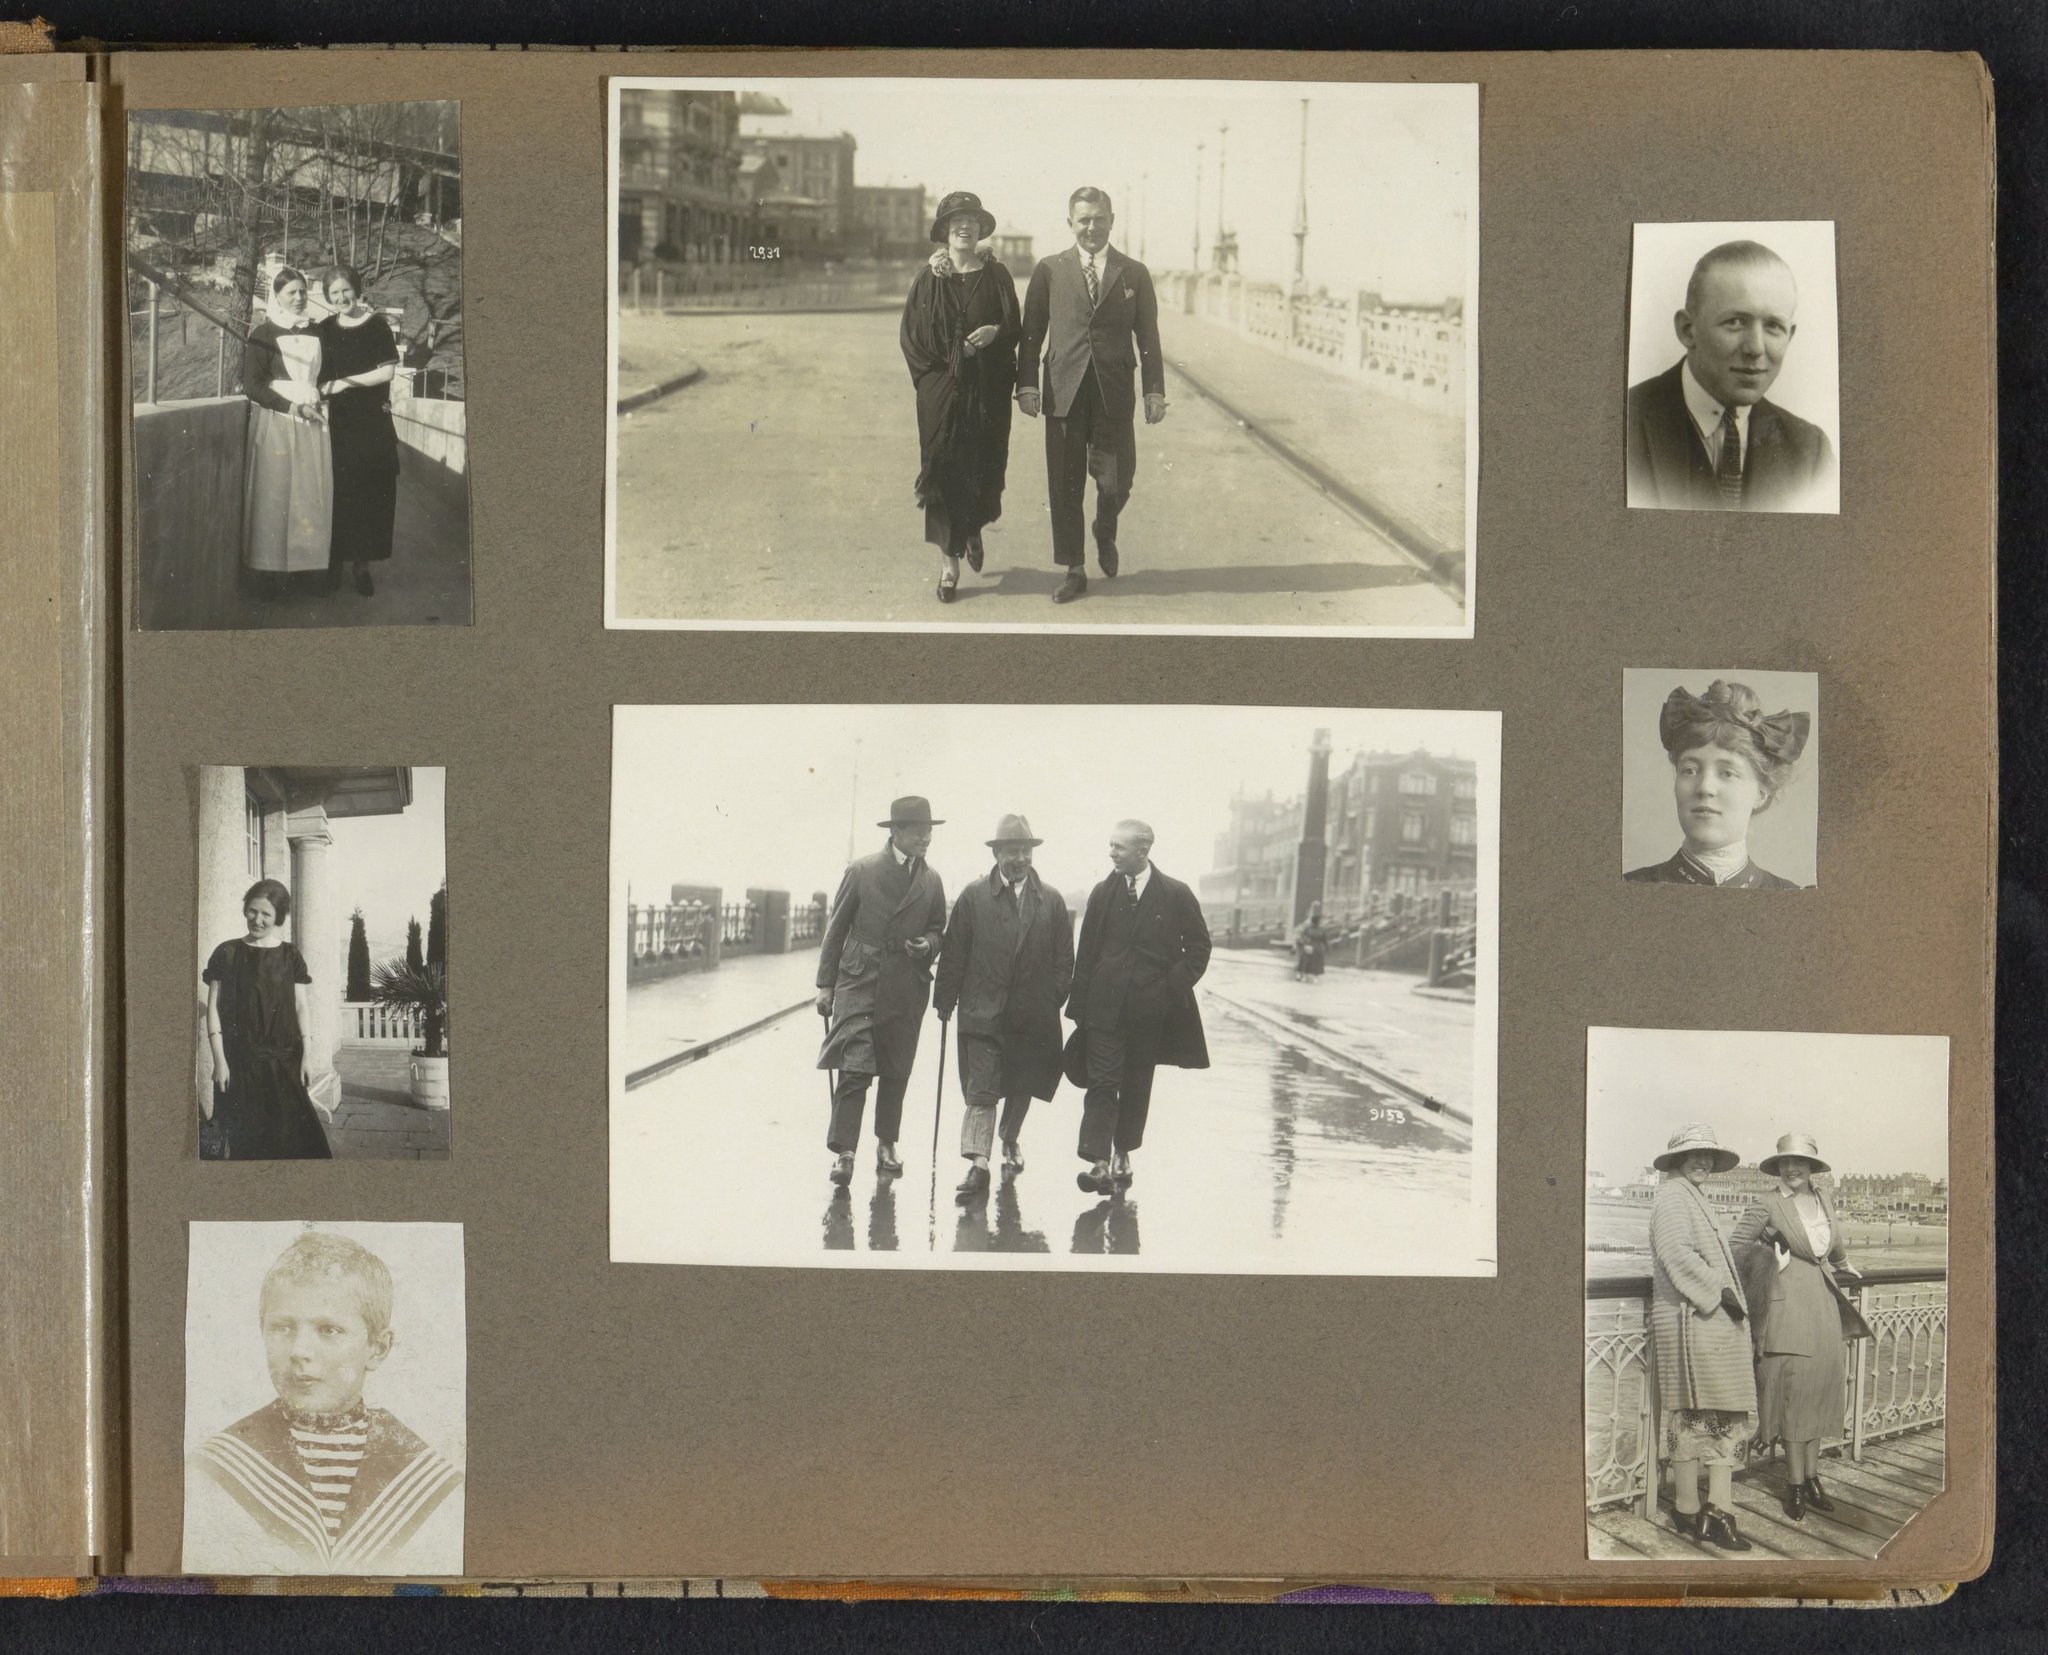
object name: photograph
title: Wandelaars en portretten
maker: Anonymous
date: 1900-1925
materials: cardboard, photographic support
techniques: gelatin silver print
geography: netherlands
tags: adult woman, strolling, nurse ~ hospital, adult man, pier, quay, wharf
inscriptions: number: ‘2931’, number: ‘9153’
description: Albumblad met foto's van wandelaars op de boulevard en pier van Scheveningen. Ook een foto van een vrouw in gezelschap van (vermoedelijk) een verpleegster. Voorts portretten van een jonge vrouw, een man en een jongen. Onderdeel van Fotoalbum van een onbekende Nederlandse familie met connecties in Suriname en Nederlands-Indië (2).